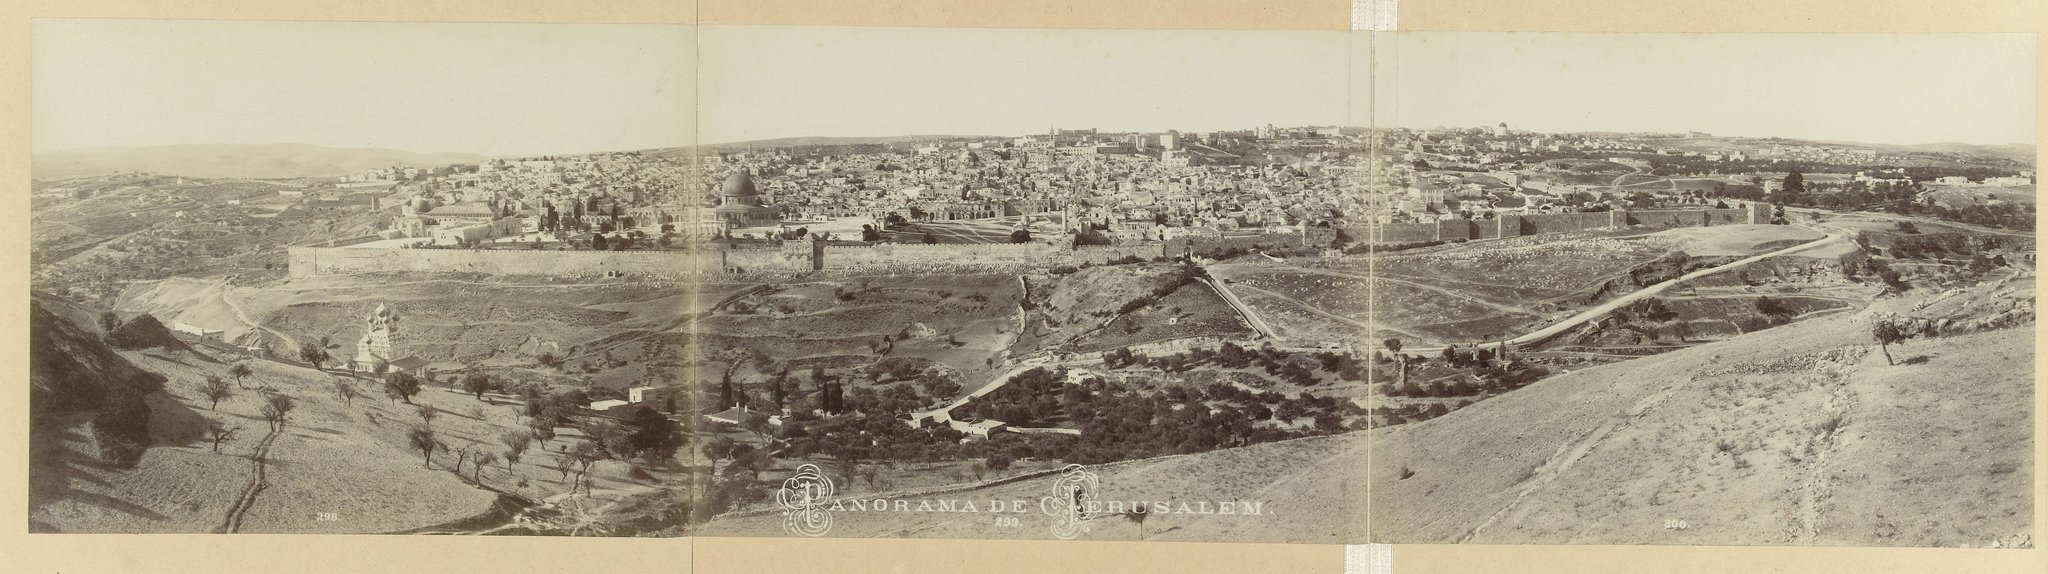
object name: photograph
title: Panorama van Jeruzalem, gezien vanaf de Olijfberg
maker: Anonymous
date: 1890-1895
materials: cardboard, paper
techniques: albumen print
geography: ottoman empire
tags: city-view in general; 'veduta'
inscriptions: stamp: ‘Gemeentelijke bibliotheek/ Rotterdam’, title: ‘S 4. A.B.C. Panorama van Jeruzalem, van den Olijfberg gezien’, number: ‘298./ 299./ 300.’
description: Onderdeel van een groep door fotograaf Richard Polak op reis verzamelde foto’s. Deze foto is samen met andere op zijn reizen verzamelde foto's tentoongesteld bij de Rotterdamsche Kunstkring (1895), Arti en Amicitiae te Amsterdam (1897-1898?) en Societeit 't Collegie te Kampen (datum vooralsnog onbekend).